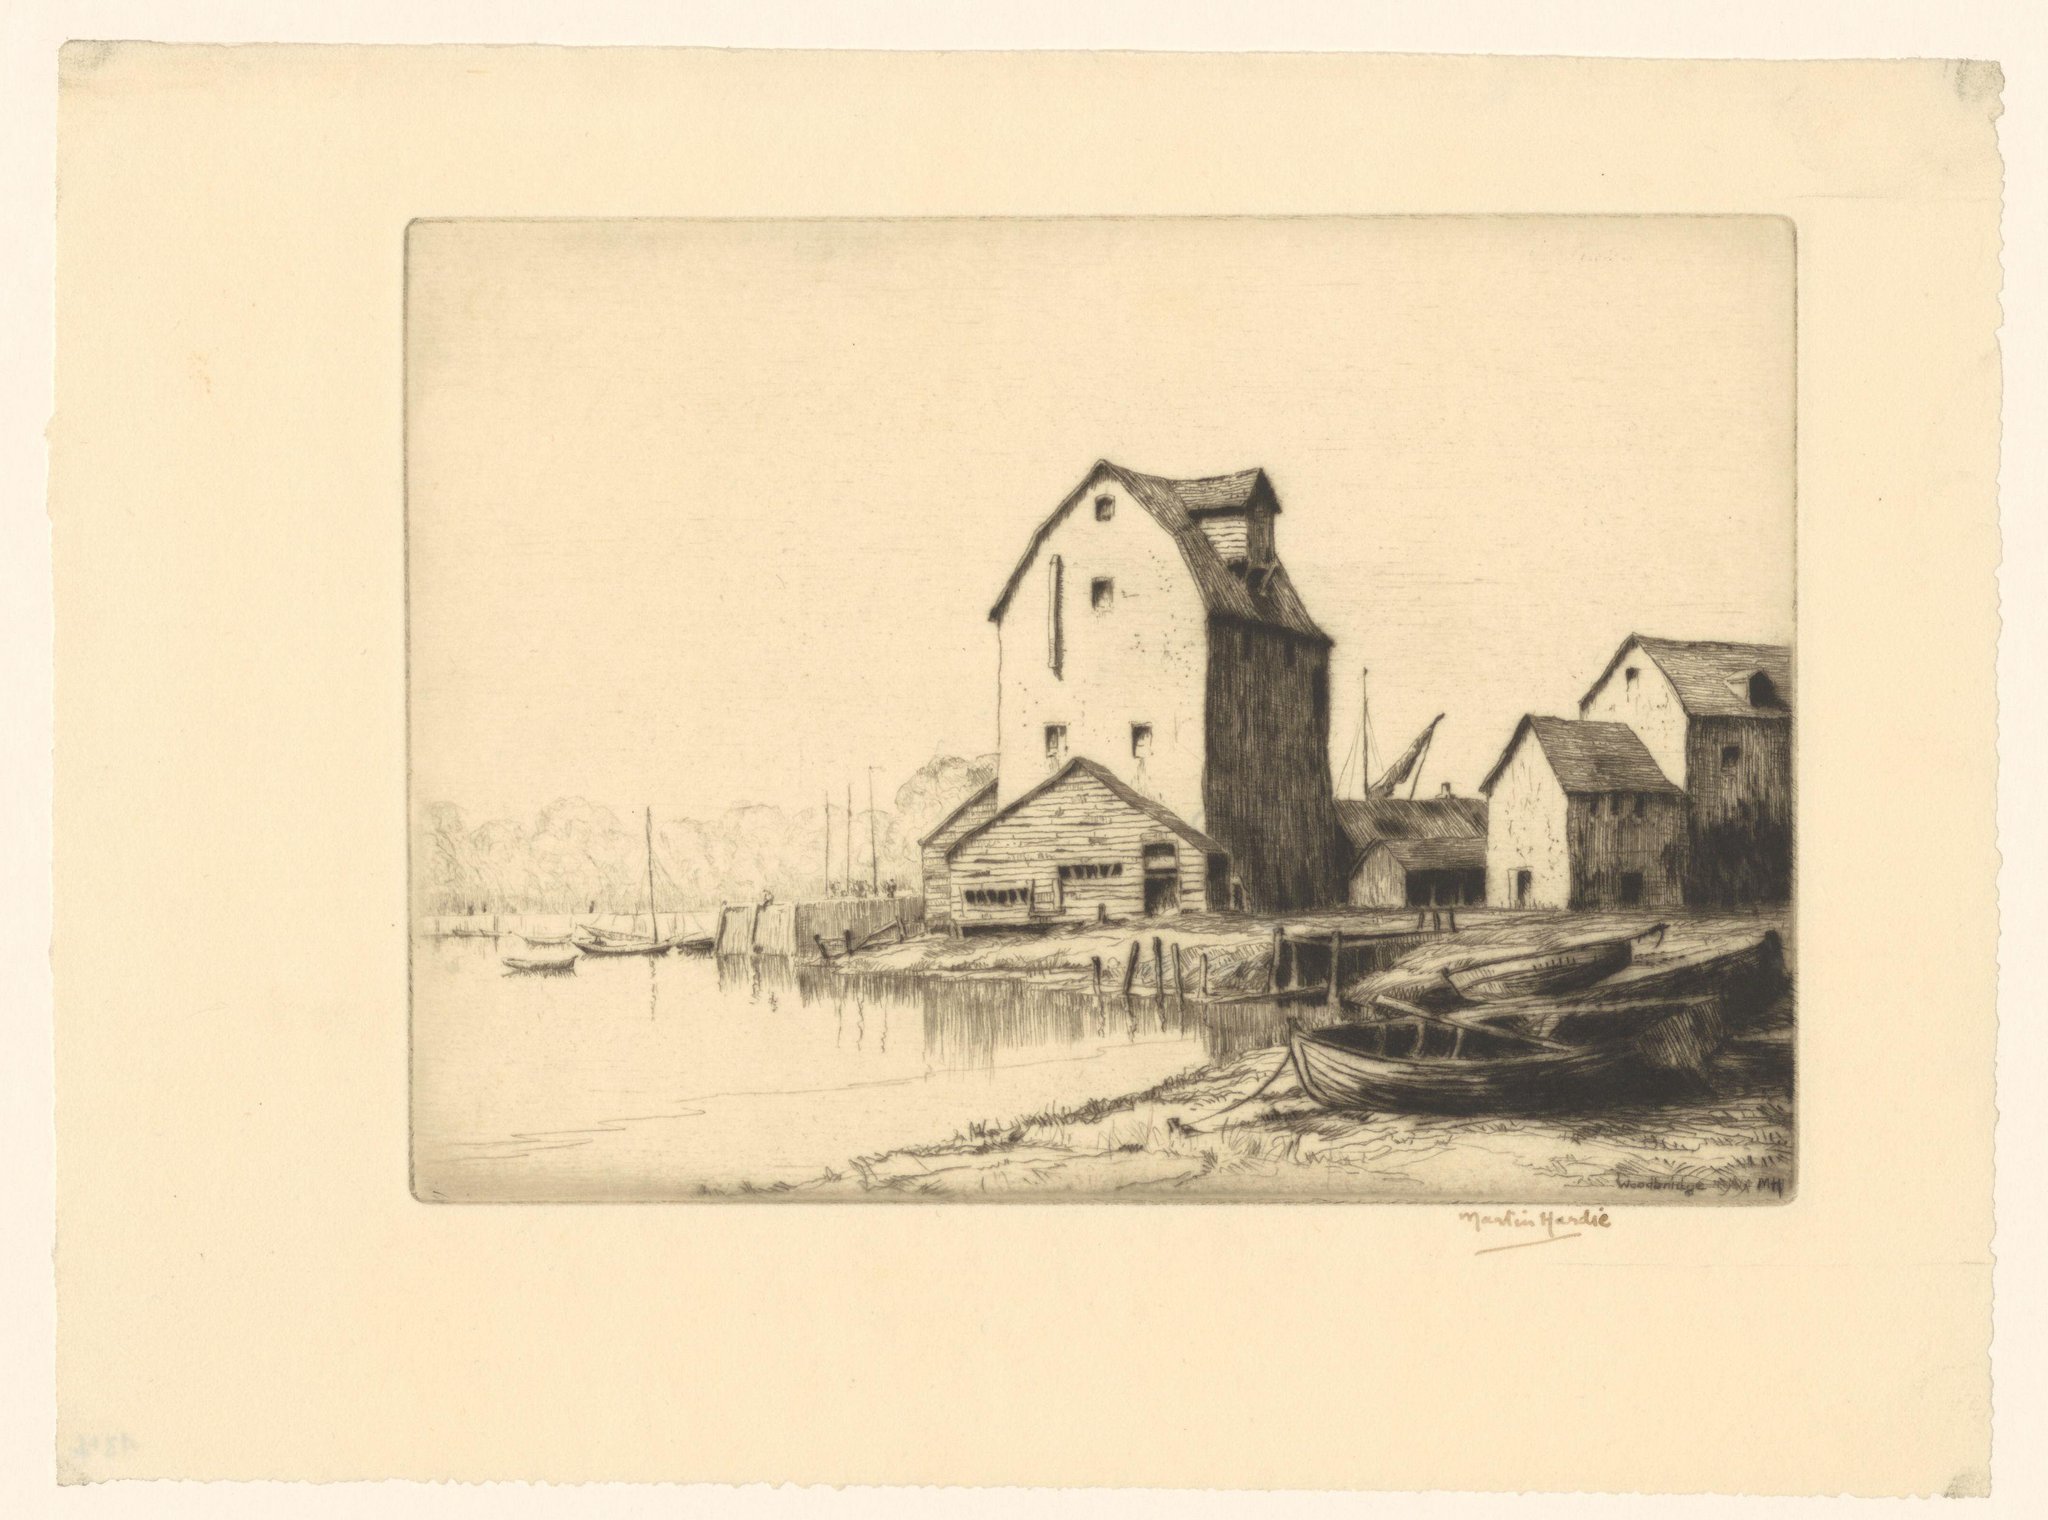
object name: print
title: The Mill at Woodbridge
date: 1930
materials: paper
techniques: drypoint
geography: woodbridge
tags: windmill in landscape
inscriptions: collector's mark: Lugt 2228, collector's mark: Lugt 2760, annotation: ‘Martin Hardie’